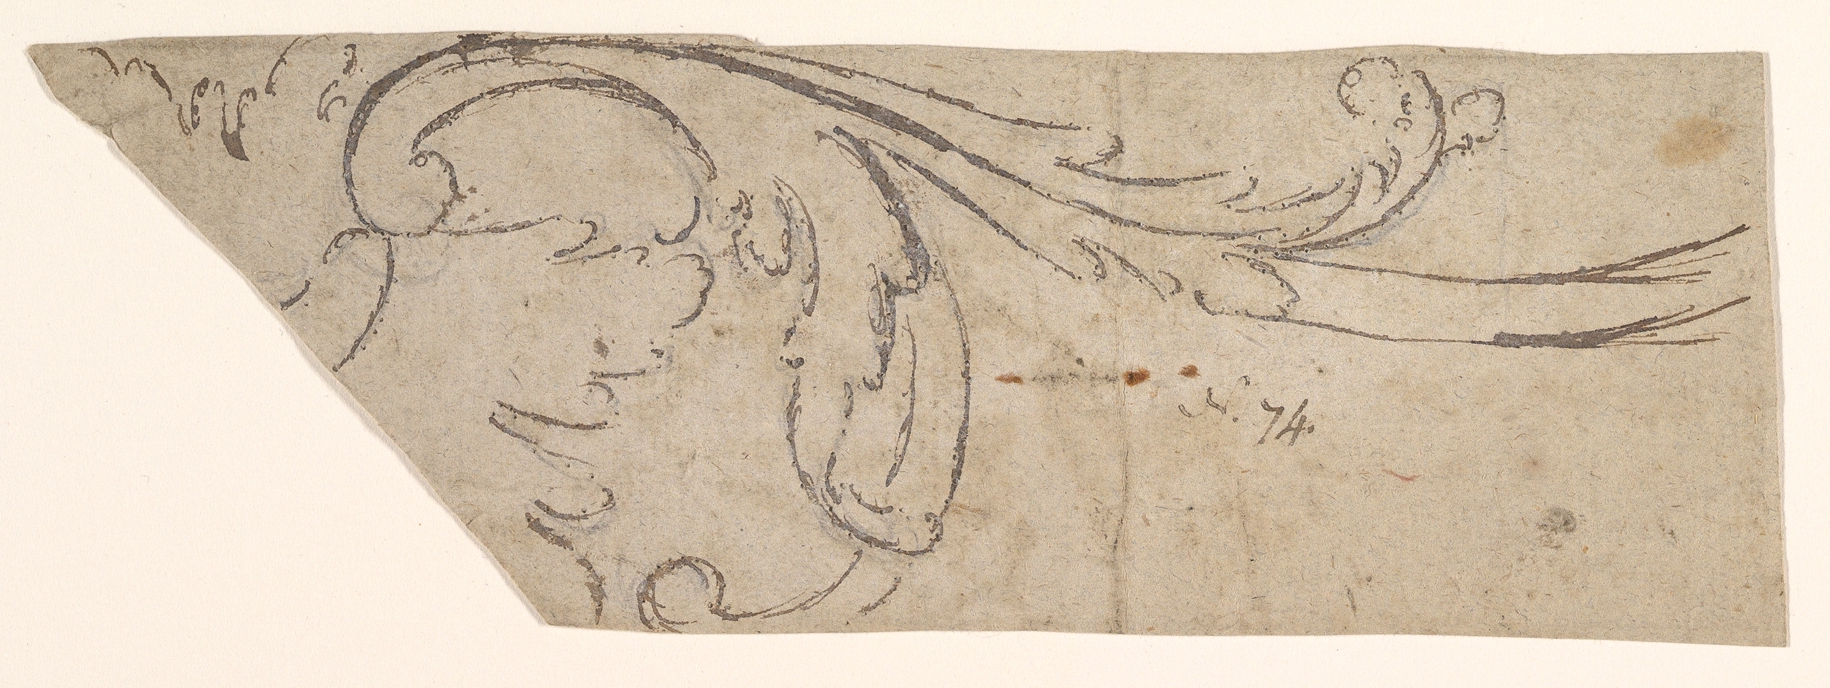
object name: drawing ornament architecture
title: Desing for a Foliate Vignette, from the so-called Scrapbook of Gideon Saint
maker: gideon saint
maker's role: artist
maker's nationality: british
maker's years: 1729-1799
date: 1760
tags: ornament